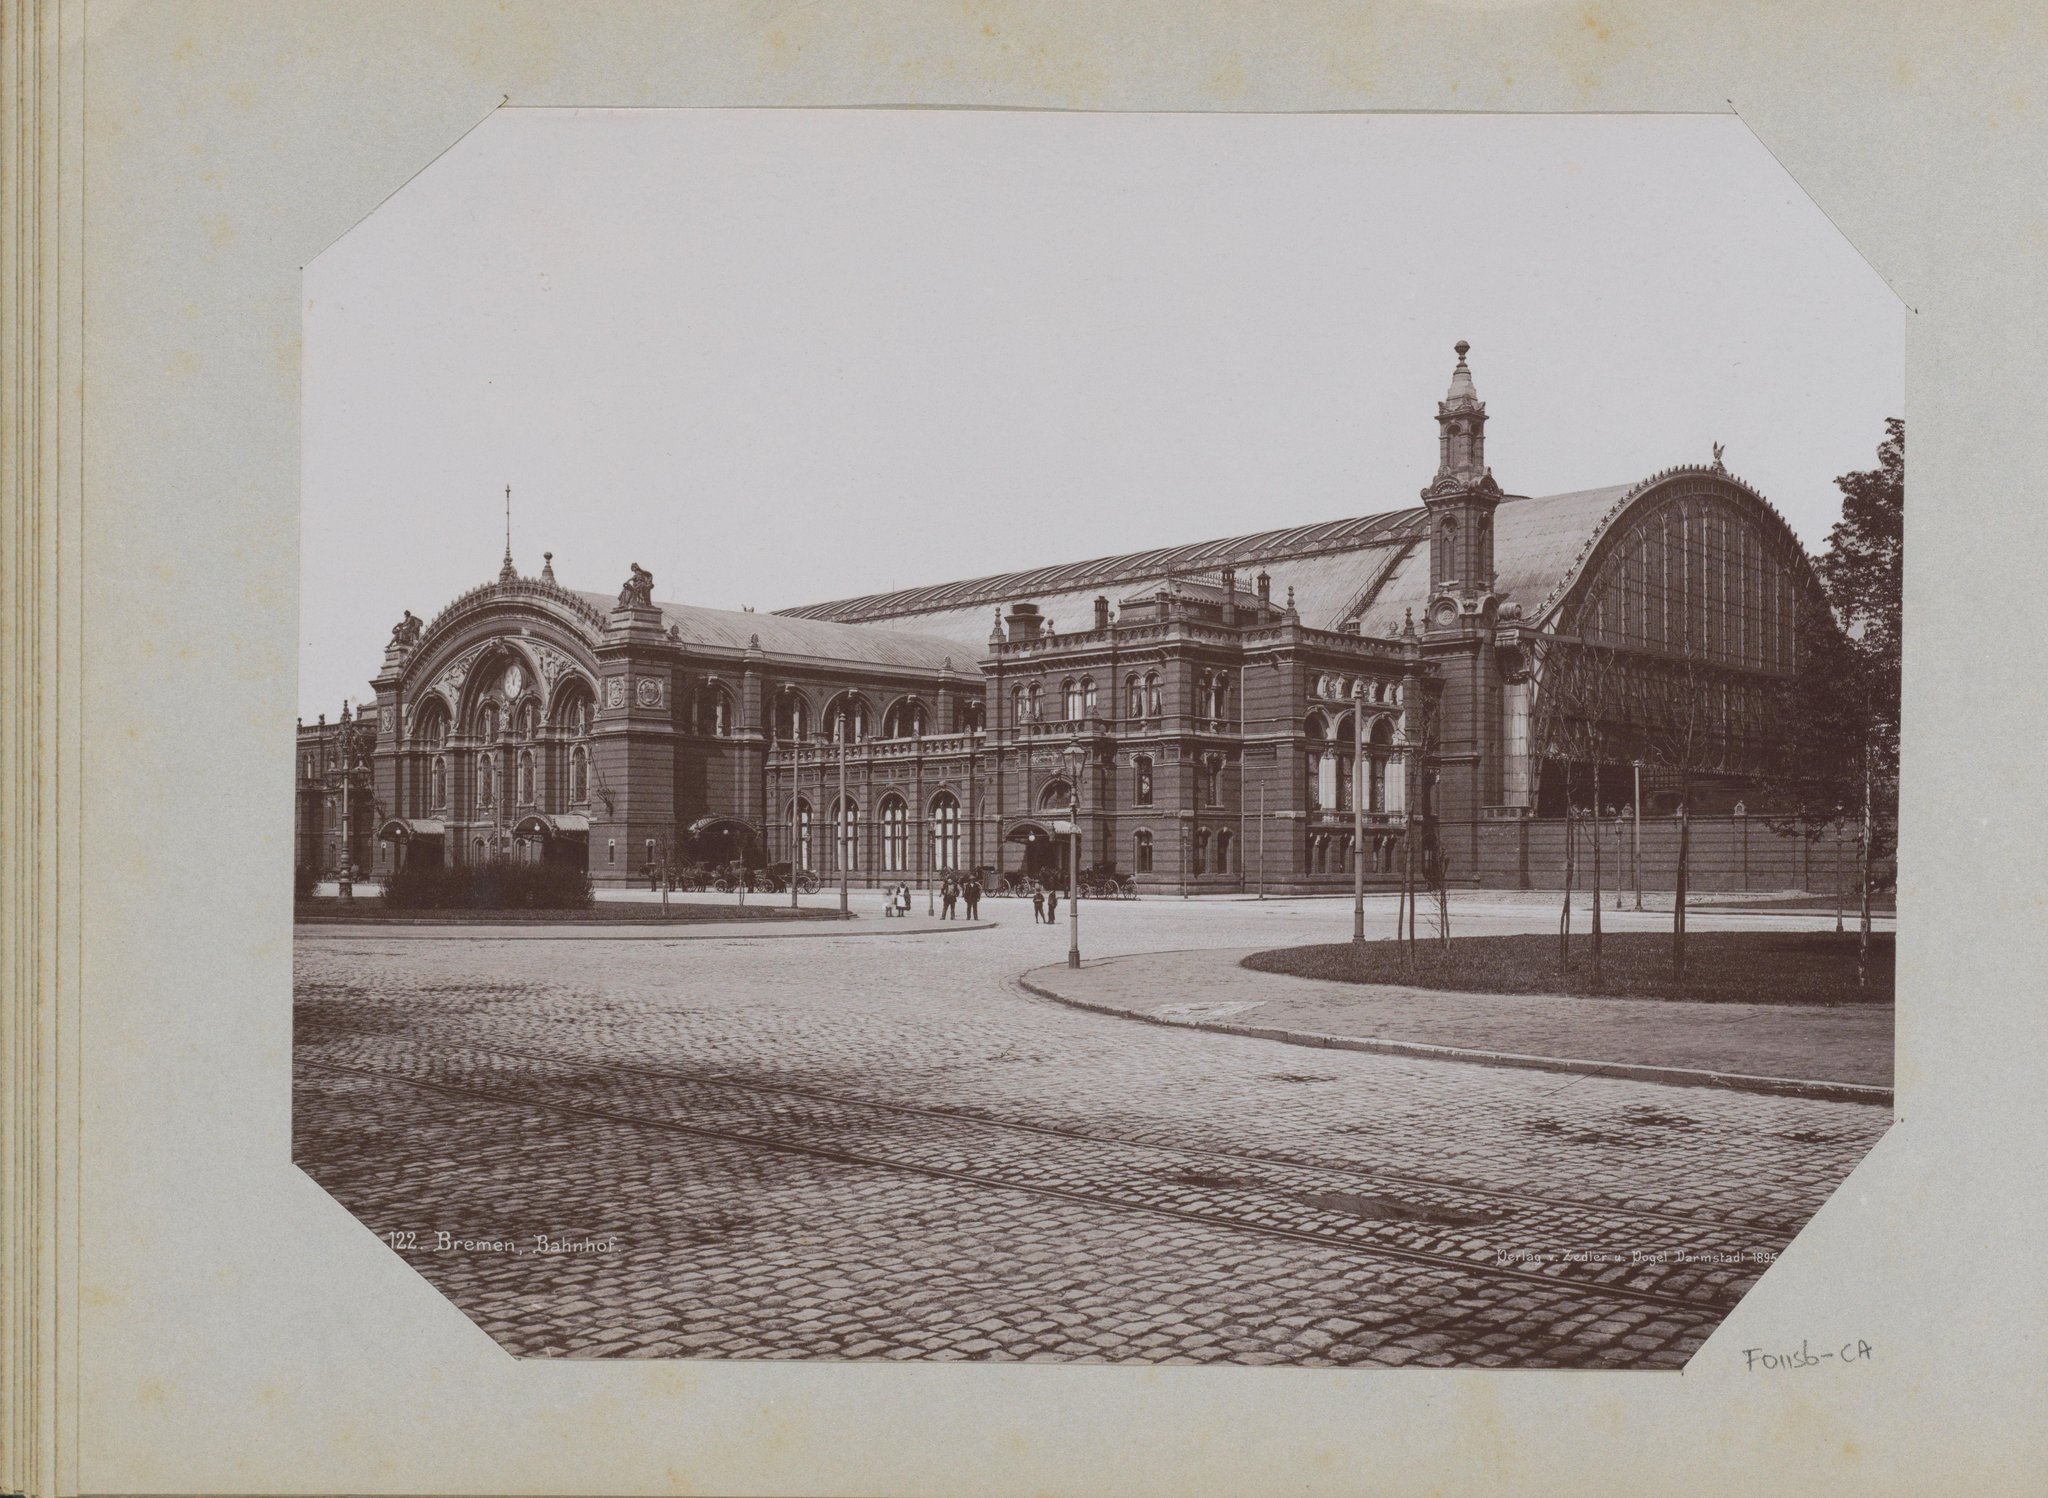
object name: album leaf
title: Gezicht op het treinstation van Bremen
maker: Anonymous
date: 1895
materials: paper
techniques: photograph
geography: darmstadt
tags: station; shelter (railway, tramway)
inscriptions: inscription: ‘122. Bremen, Bahnhof/ Verlag v. Zedler u Vogel Darmstadt 1895’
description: Deze prent maakt deel uit van een album.